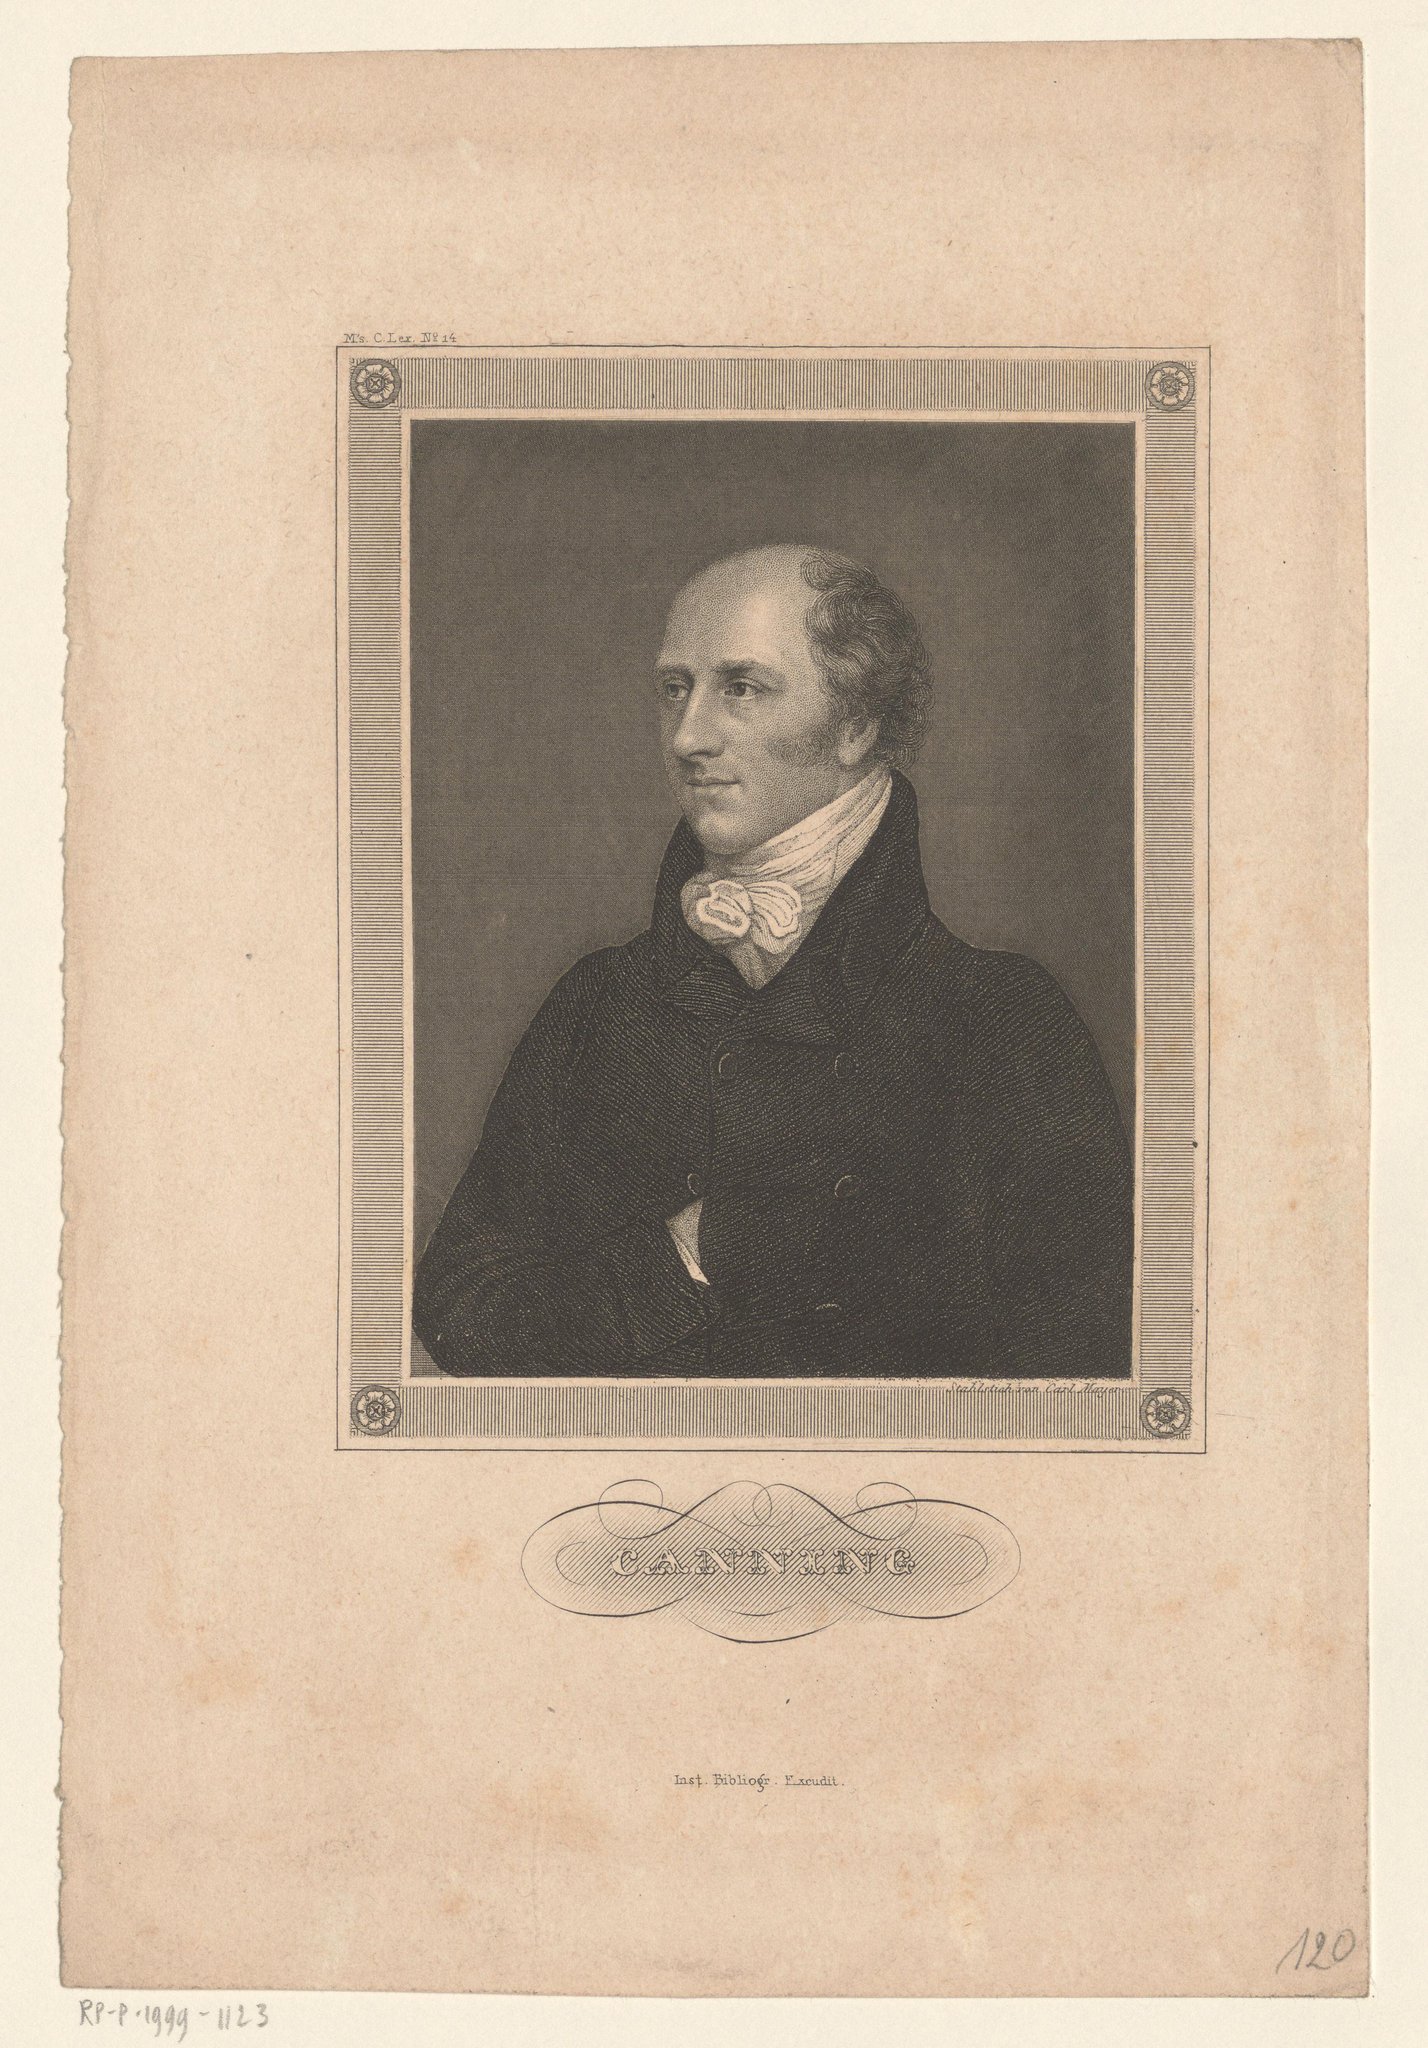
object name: print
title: Portret van George Canning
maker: carl mayer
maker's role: print maker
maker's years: 1798-1868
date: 1829-1840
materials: paper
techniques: engraving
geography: hildburghausen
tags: london, historical persons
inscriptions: collector's mark: Lugt 2228